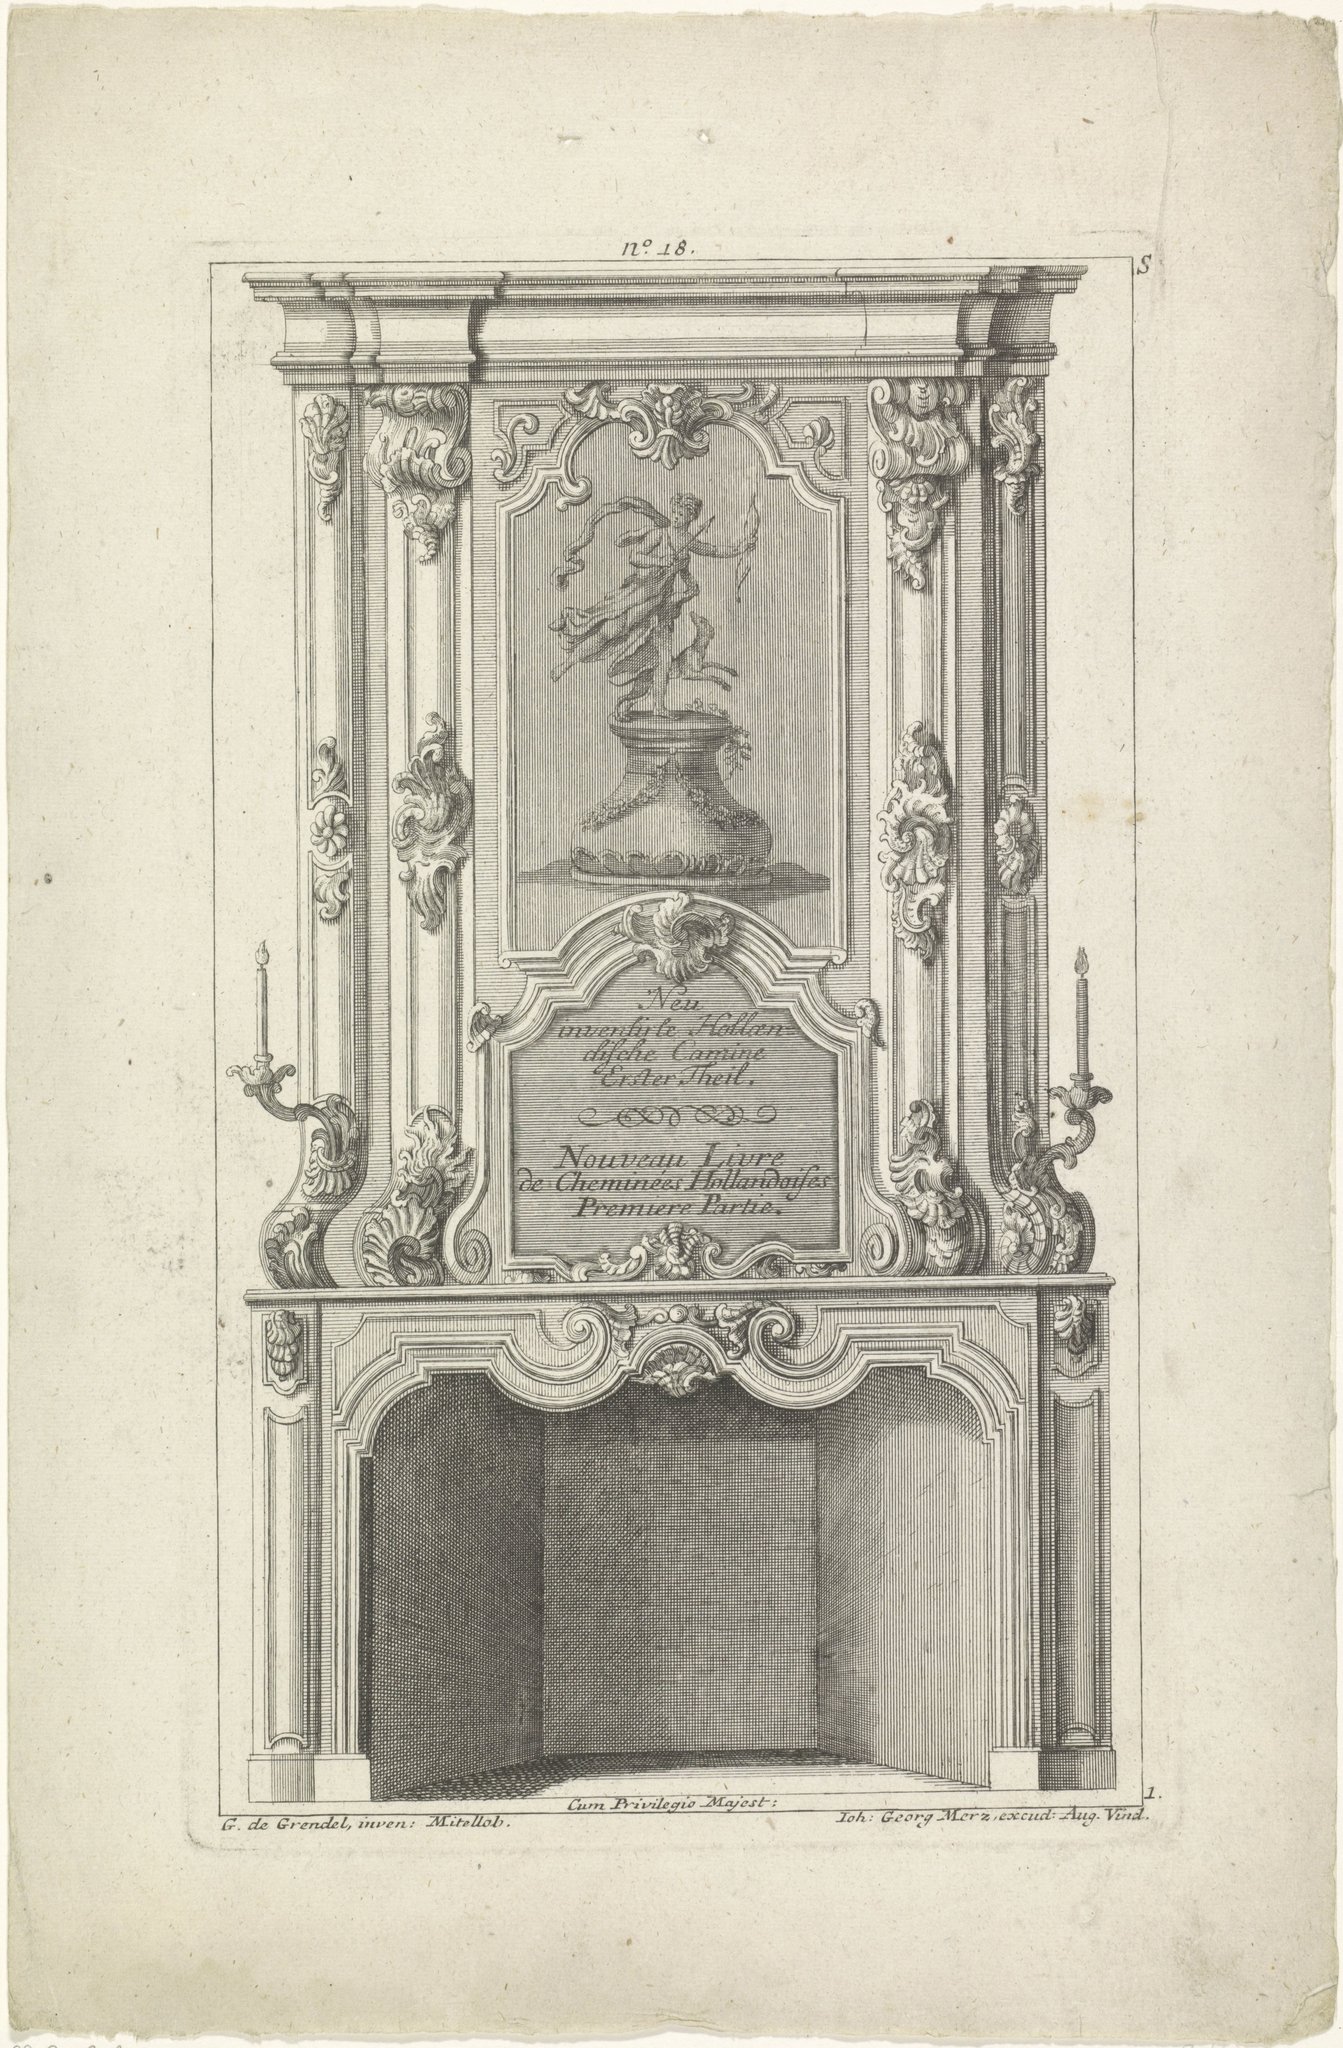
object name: titelprent, frontispice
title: Neu inventirte Hollaendische Camine, Erster Theil / Nouveau Livre de Chéminees Hollandoises Premiere Partie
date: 1709-1762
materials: paper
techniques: engraving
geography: augsburg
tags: chimney, rocaille ornament, (story of) diana (artemis)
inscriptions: collector's mark: Lugt 2228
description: Ontwerp voor een schoorsteen met een voorstelling van Diana met pijl en boog in de handen en een jachthond op een voetstuk. De schoorsteenmantel is versierd met rocailleornamenten en voluten. Aan weerzijden een kandelaar. Midden boven genummerd: No. 18.